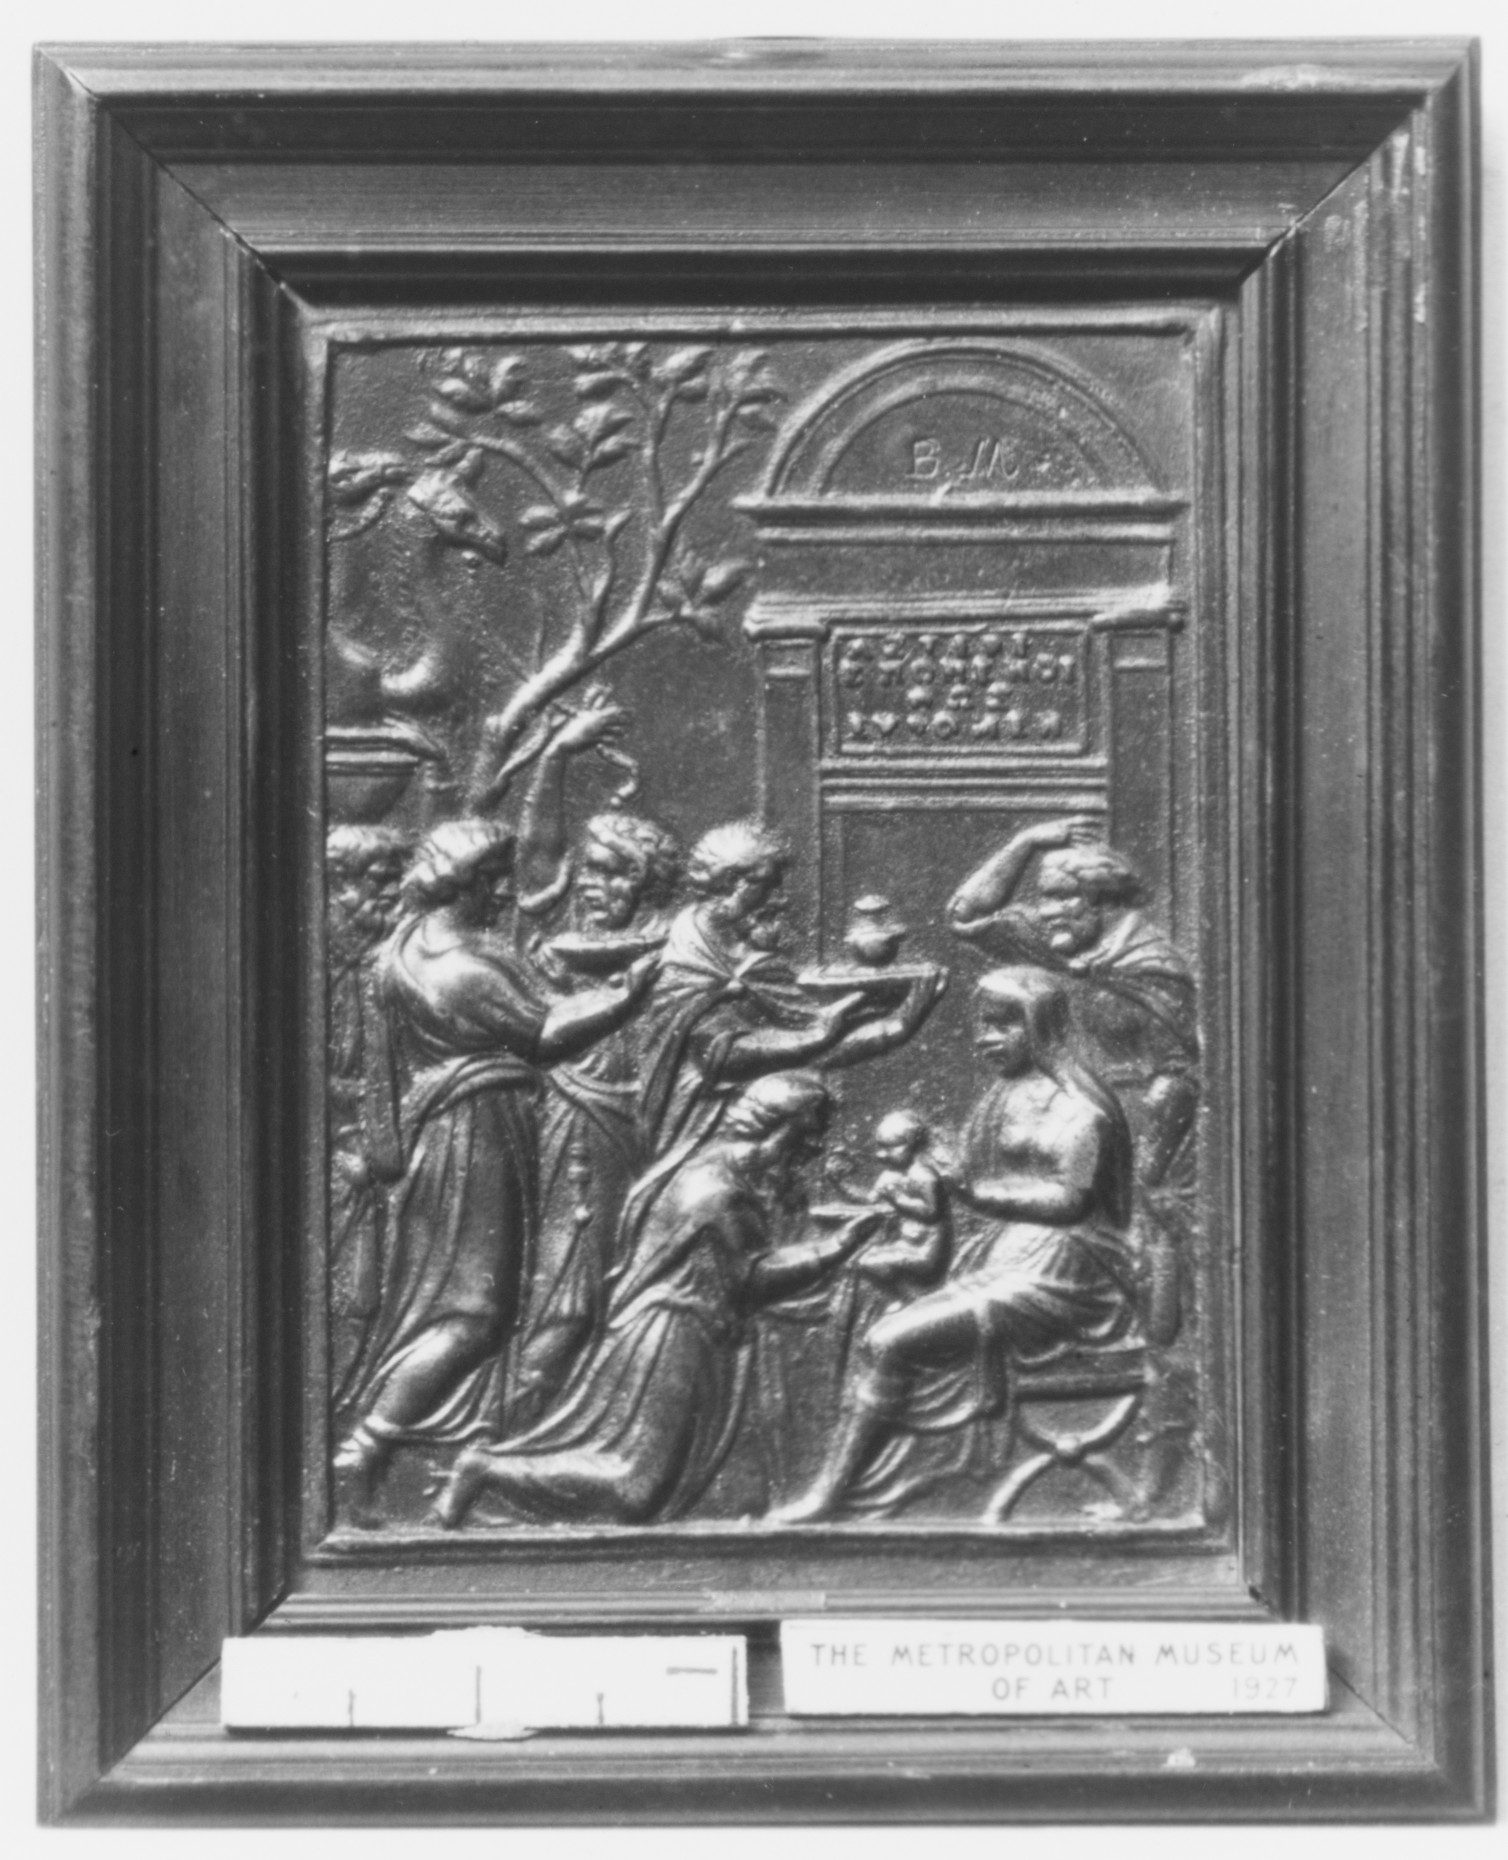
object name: plaquette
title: Adoration of the Magi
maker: valerio belli (il vicentino)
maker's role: artist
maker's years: 1468-1546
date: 1467-1533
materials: bronze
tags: infants,men,women